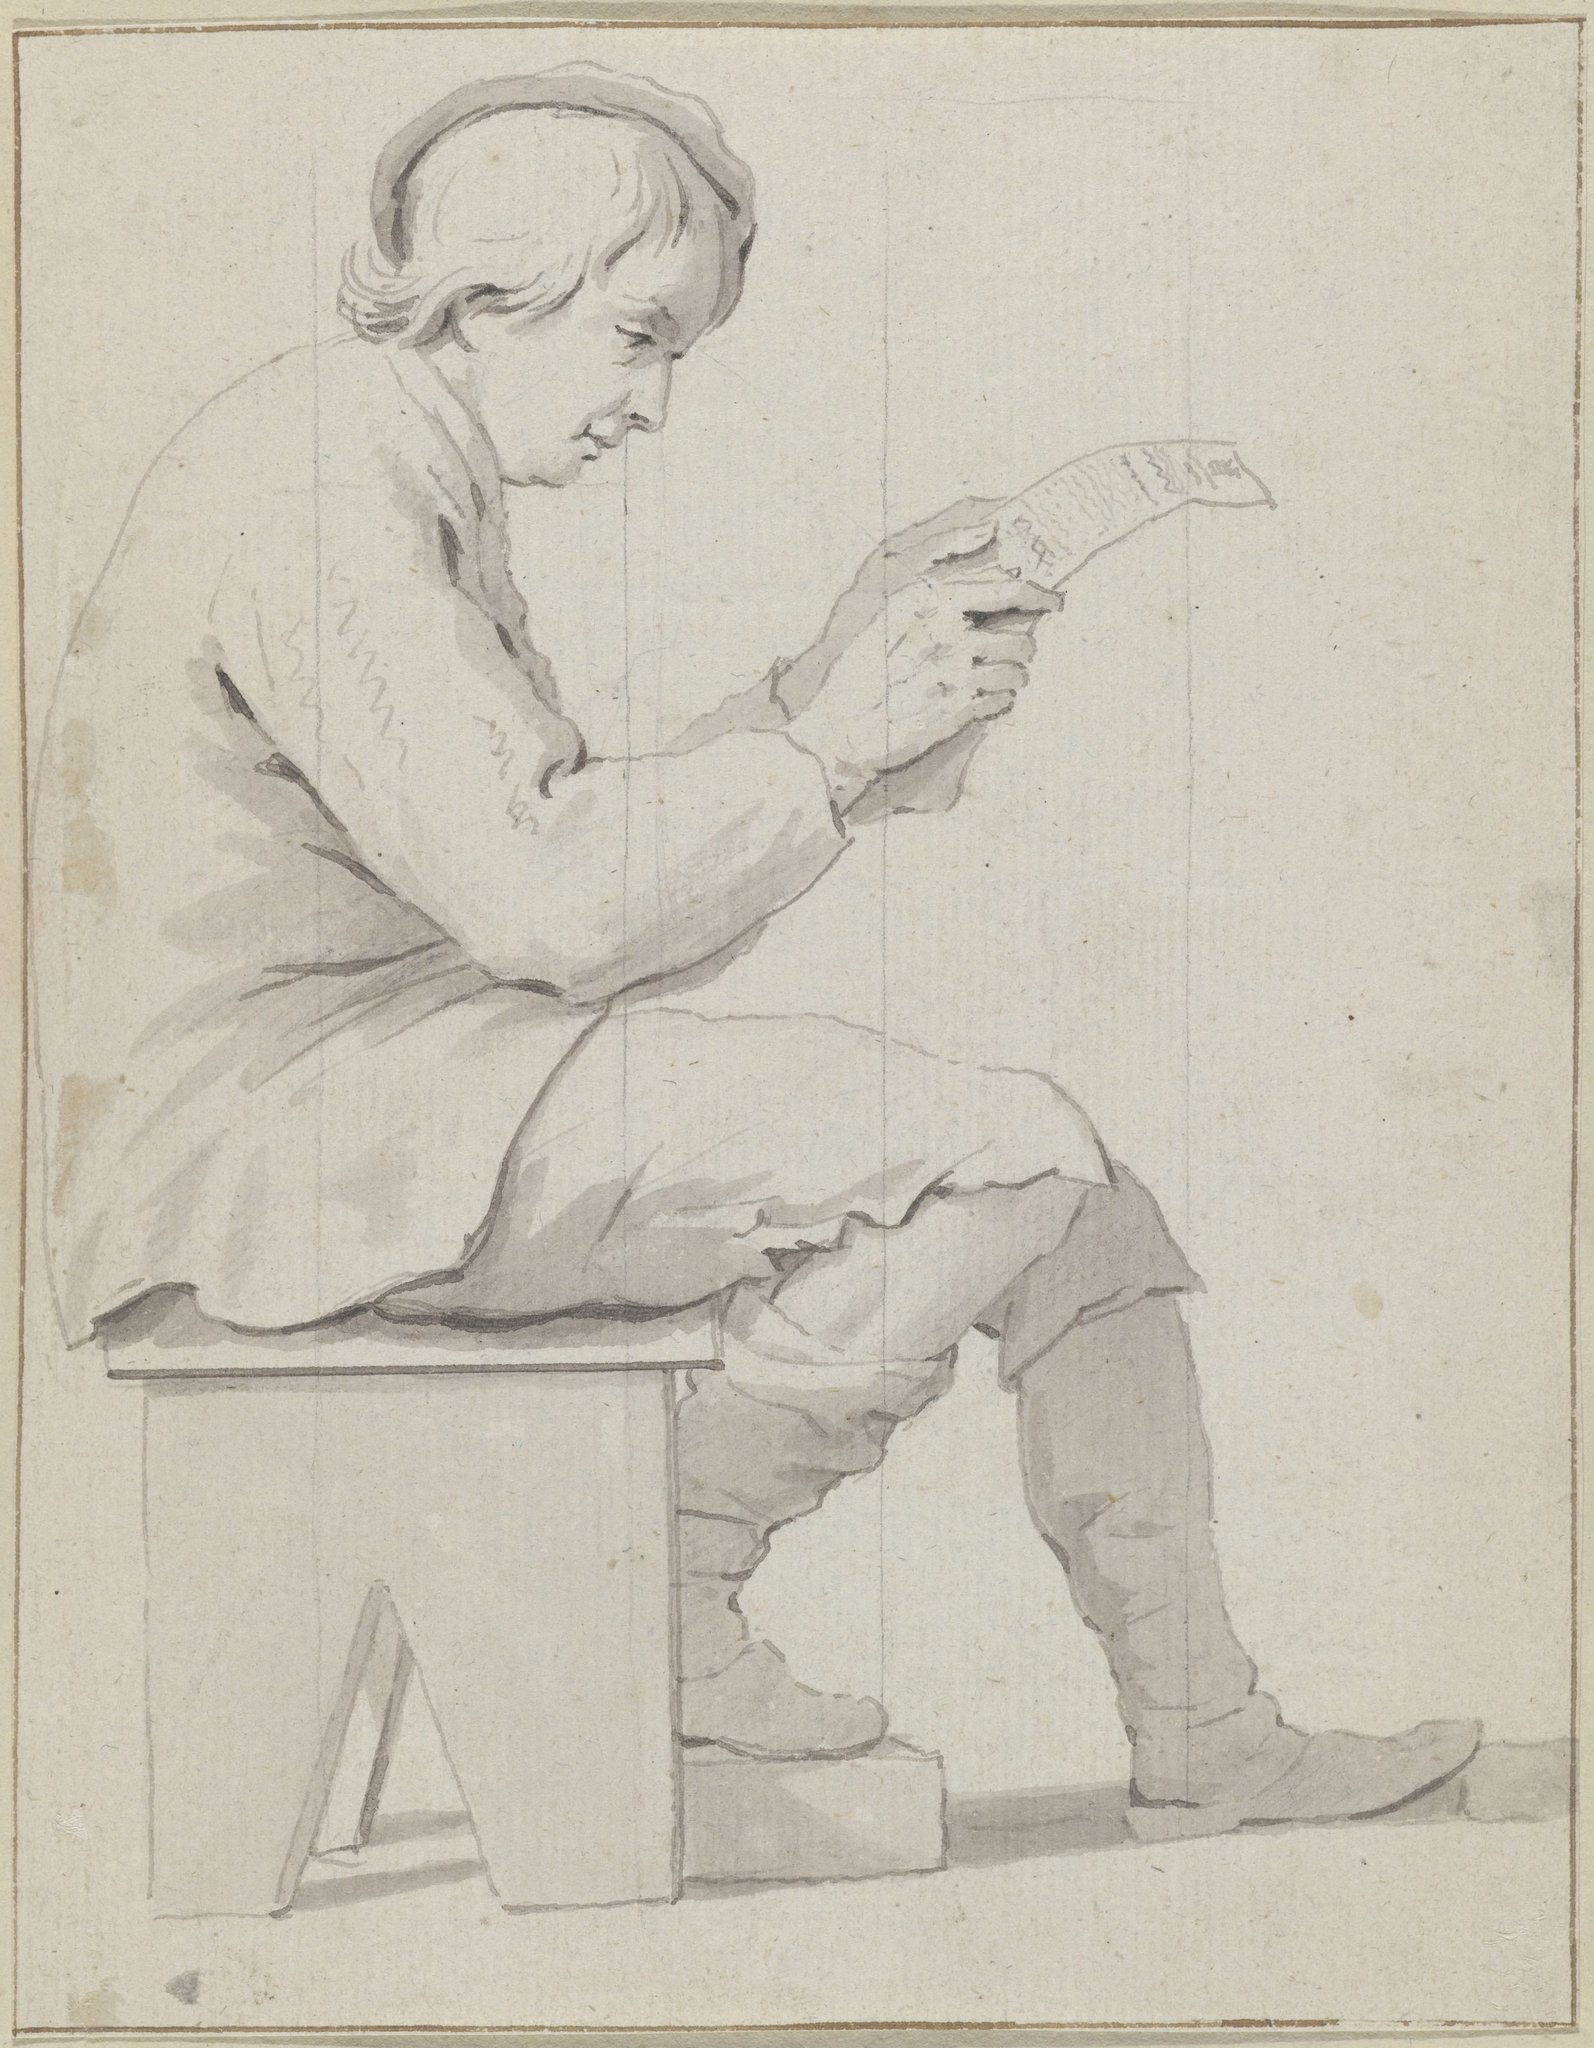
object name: drawing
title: Op een kruk zittende jongeling met een document in zijn handen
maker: Anonymous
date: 1700-1799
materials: ink, paper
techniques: brush, pen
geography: netherlands